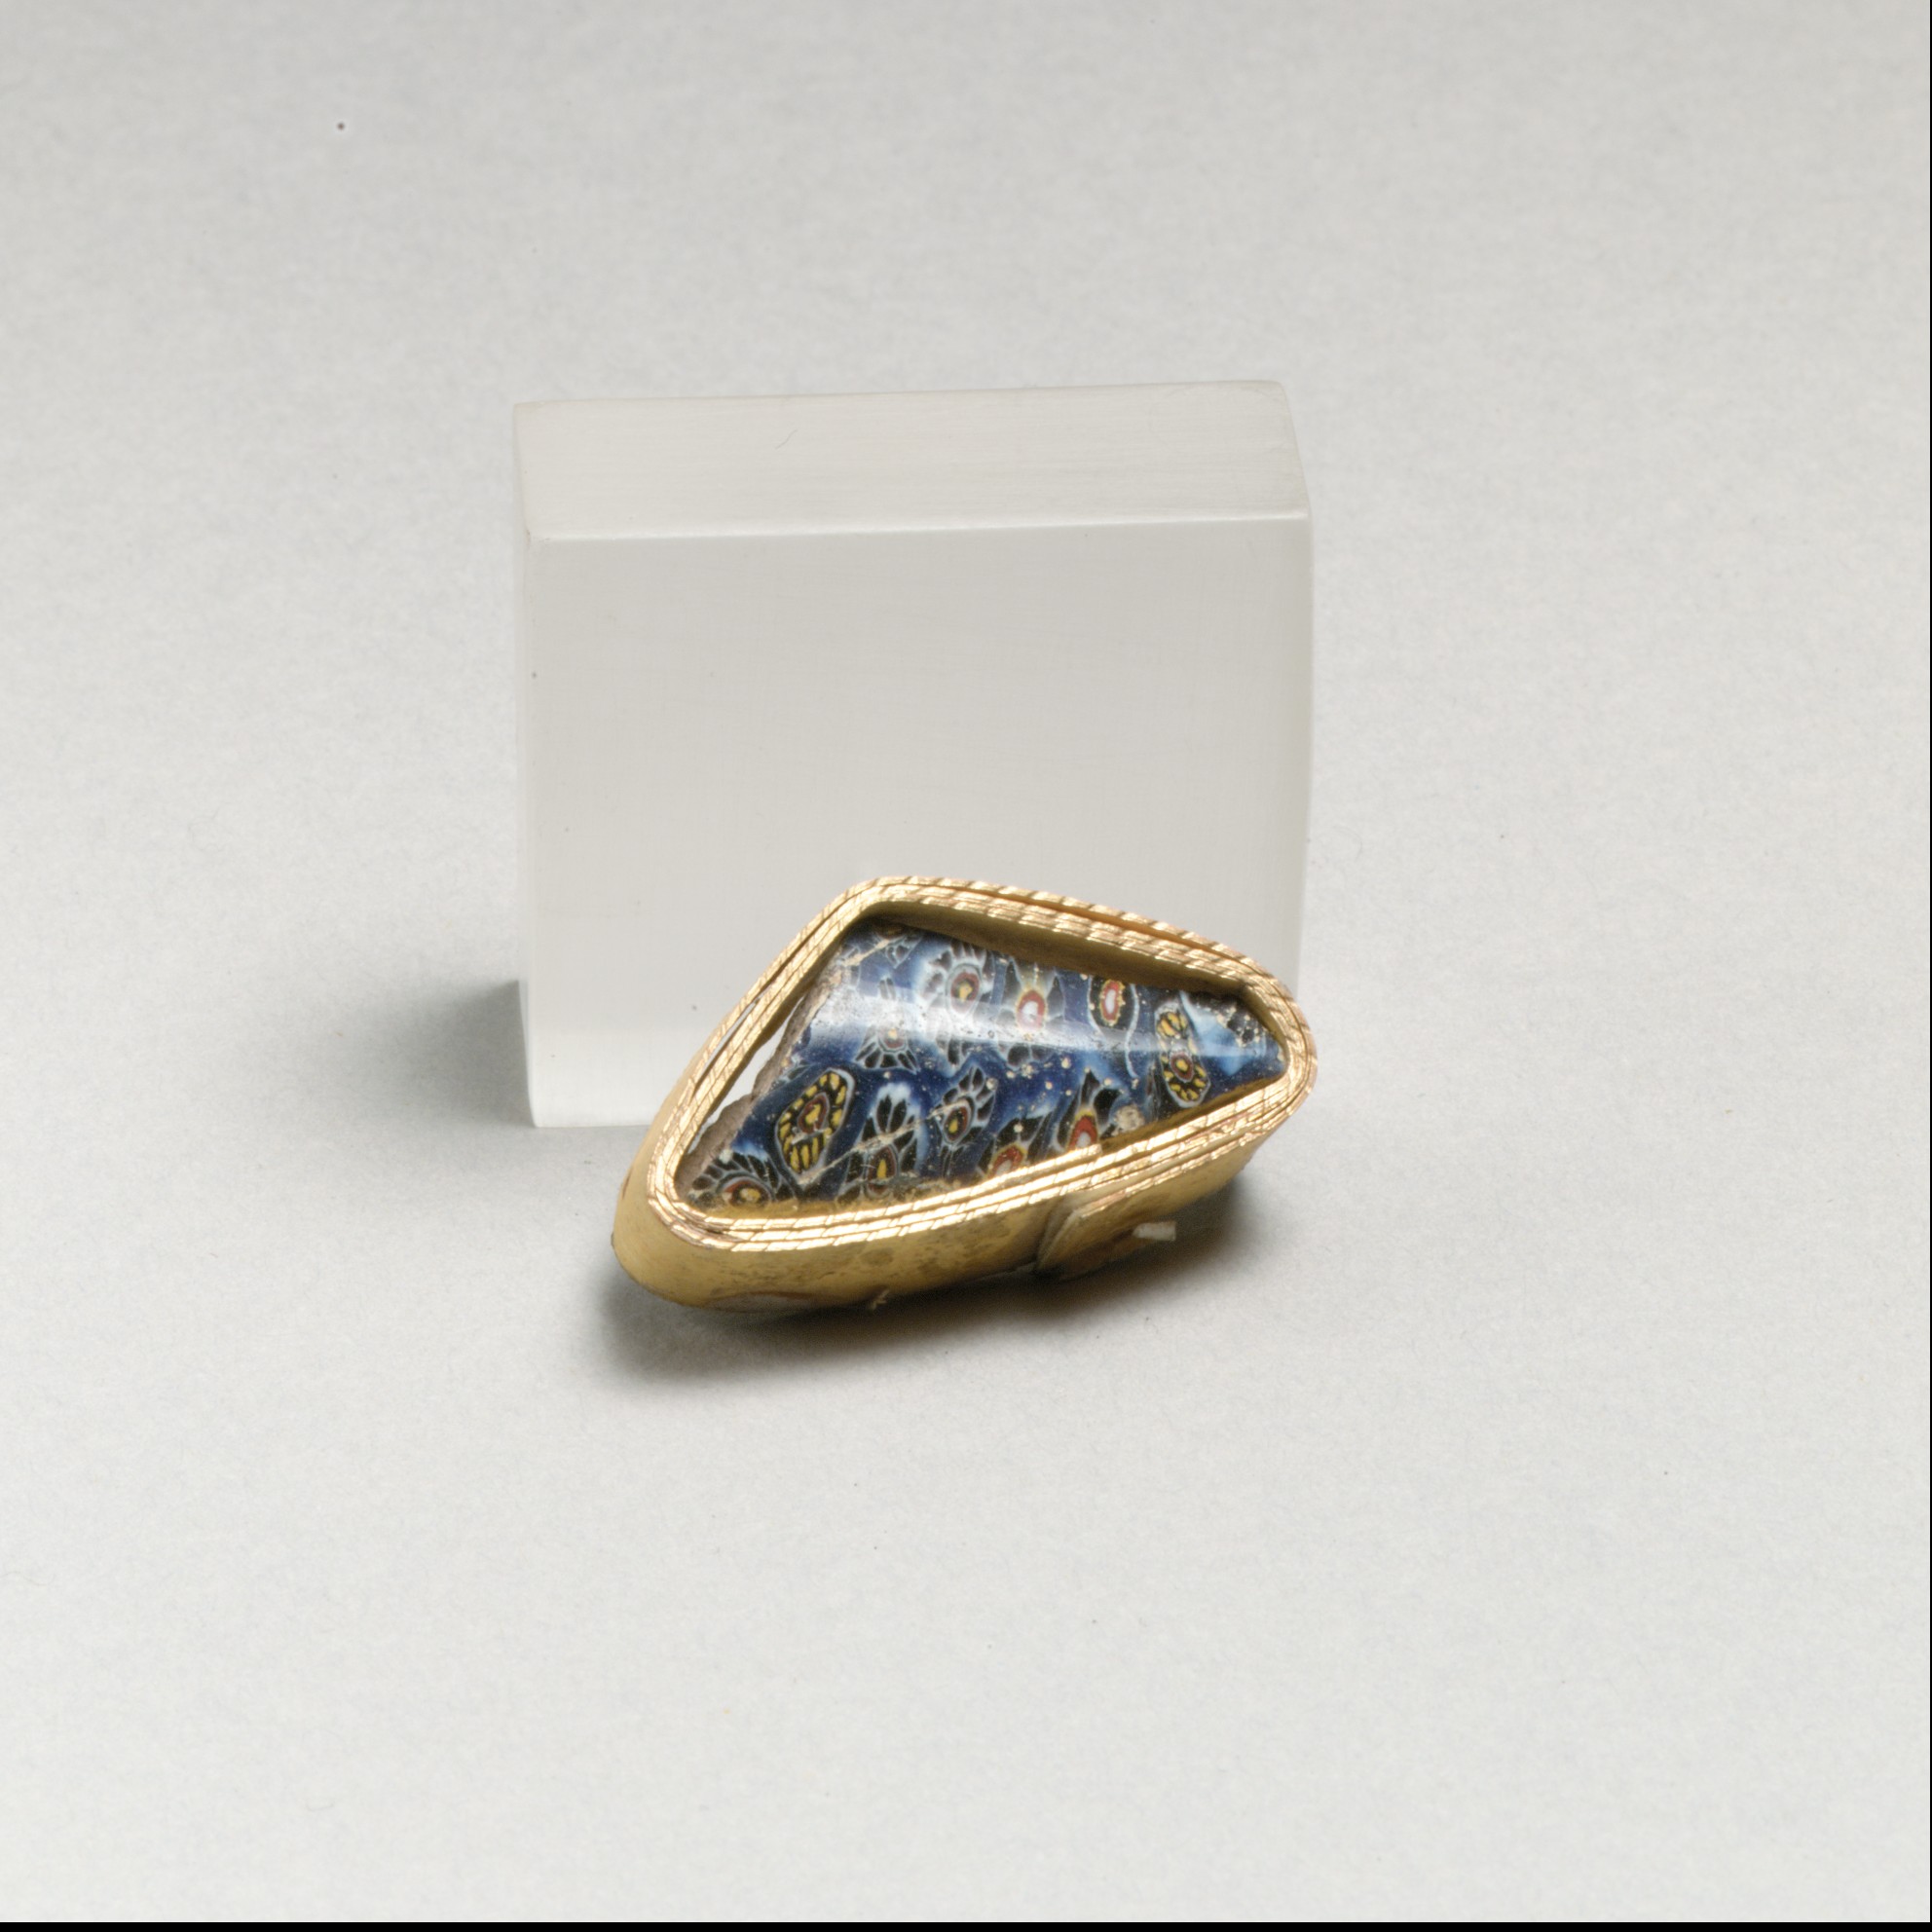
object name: fragment, mosaic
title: Glass mosaic fragment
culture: roman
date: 34 BCE-33 CE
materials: glass